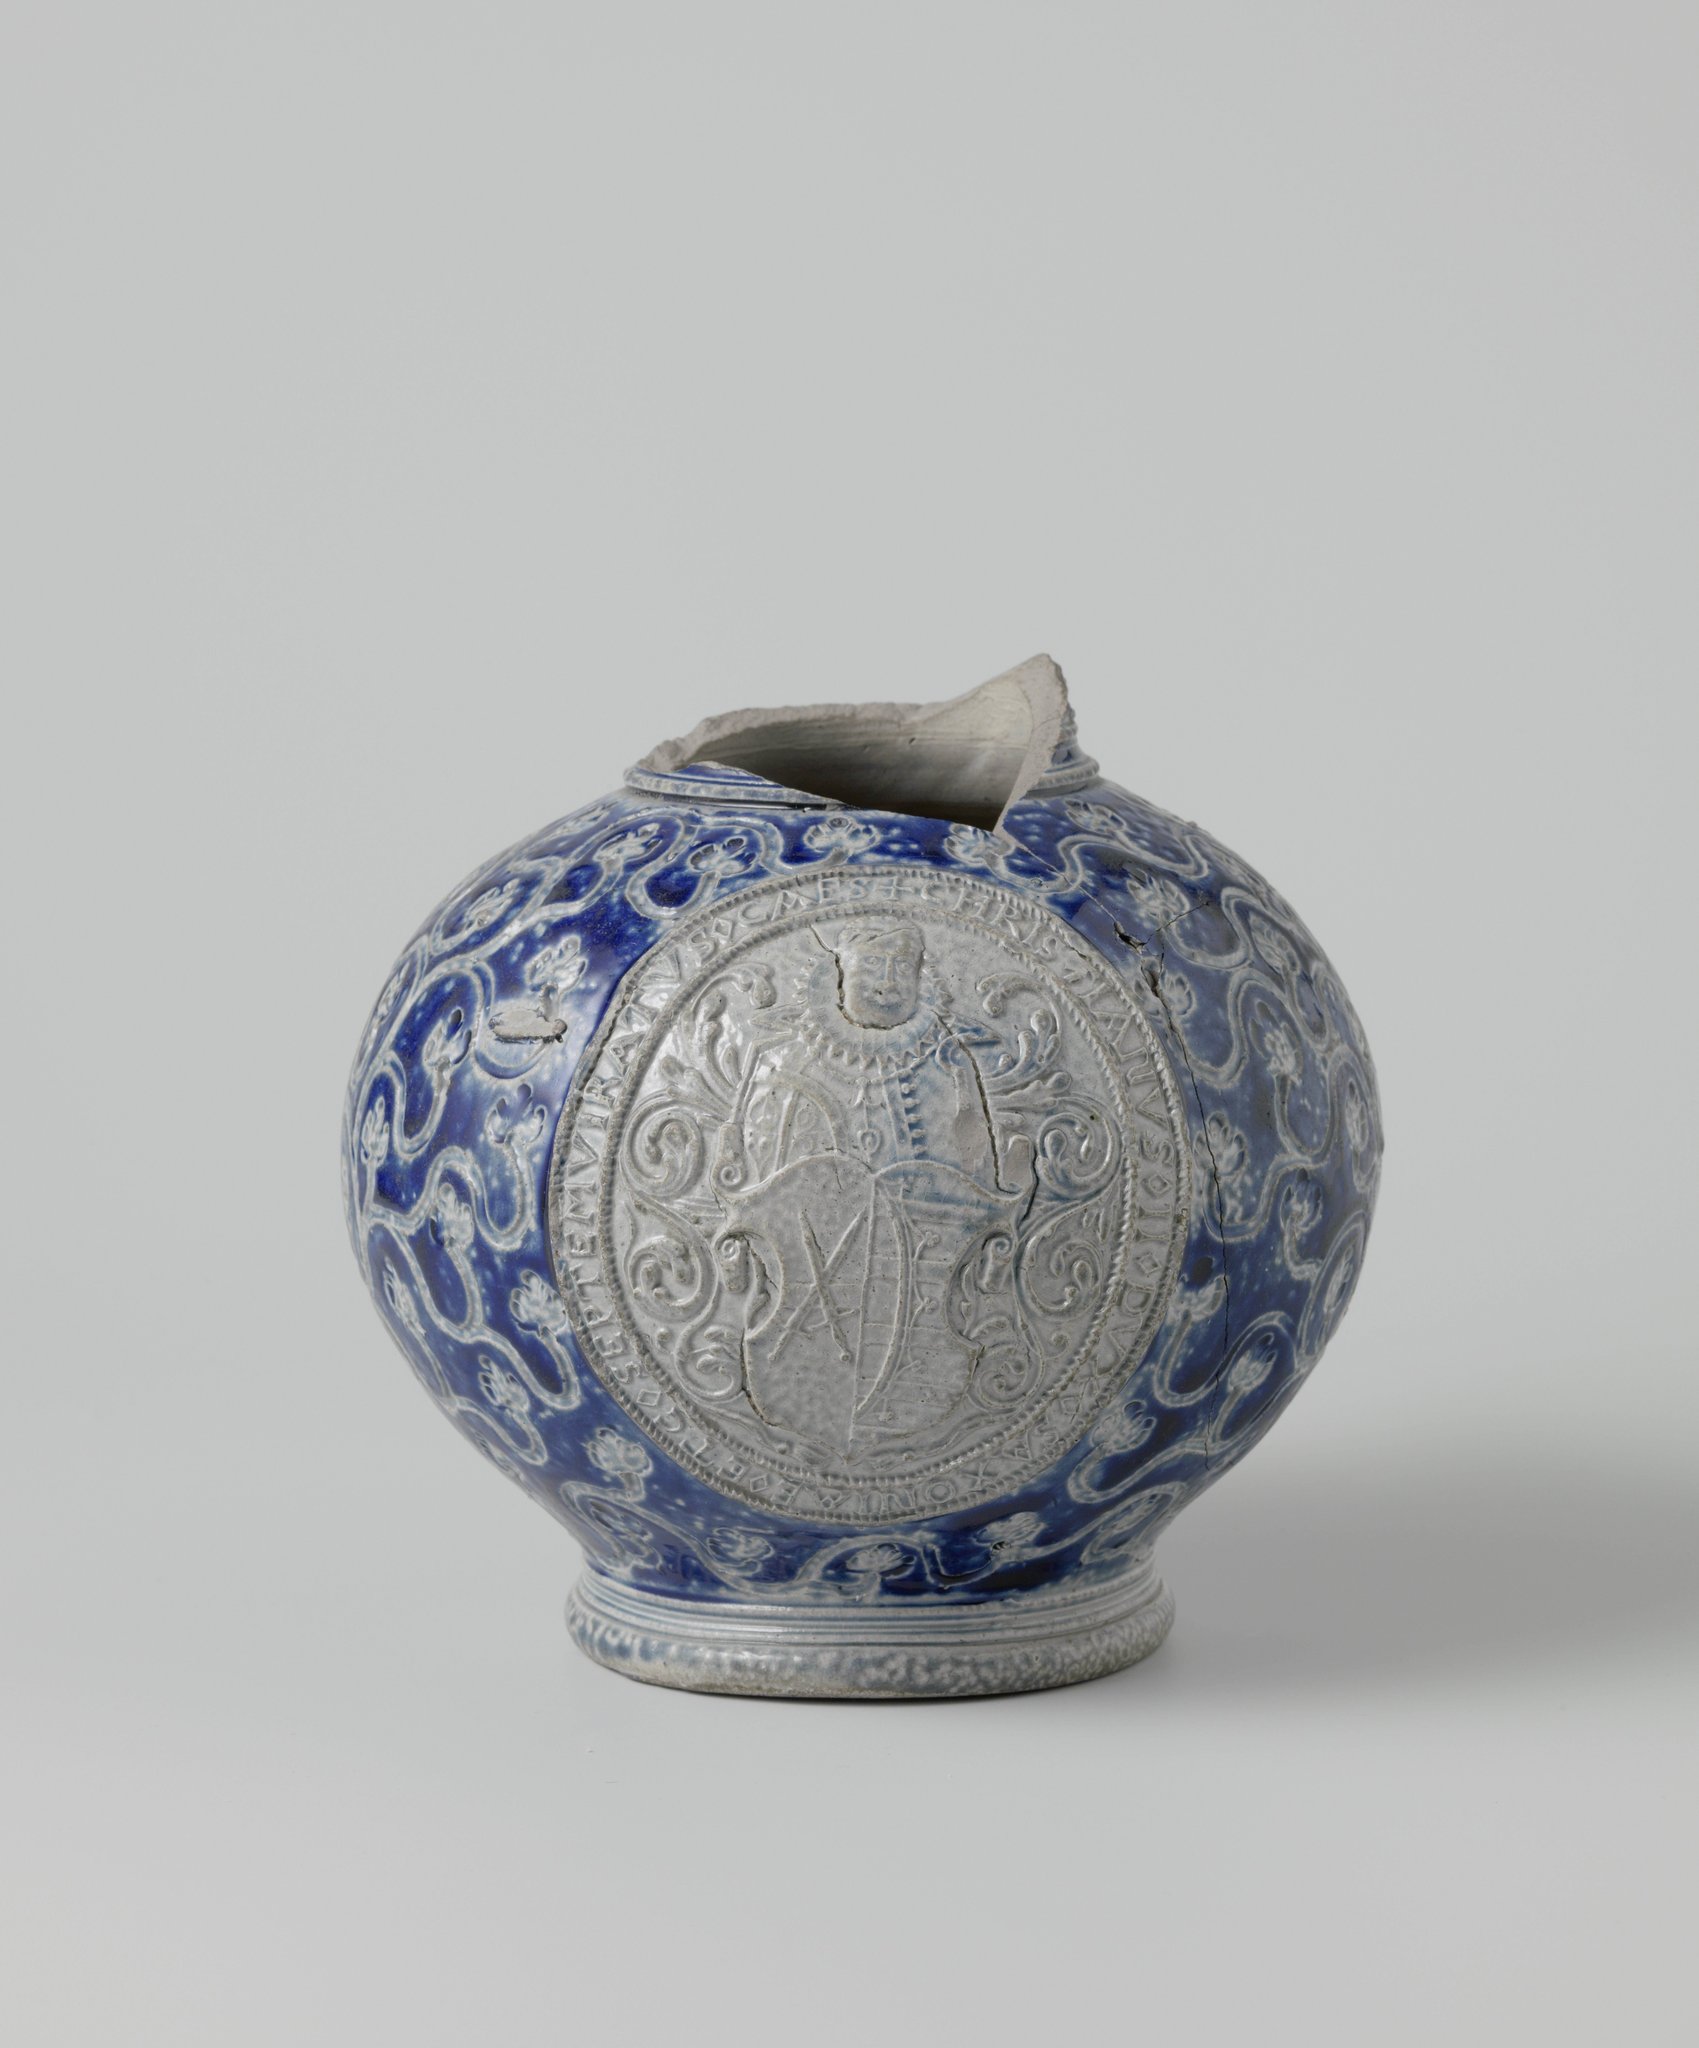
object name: fragment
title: Fragment of a jug with a portrait of Christan II, Elector of Saxony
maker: Anonymous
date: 1590-1620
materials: cobalt, glaze, stoneware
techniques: printing, firing, forming, relief, turning, vitrification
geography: raeren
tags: keurvorst, christiaan ii van saksen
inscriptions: inscription: ‘CHRISTIANVS II DVX SAXONIAE ETC SEPTEMVIRATVS CAES’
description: Fragment van een kruik van steengoed op standring met een bolvormig lichaam. Nek en oor ontbreken. Gedeeltelijk bedekt met kobaltblauw. Op de buik in reliëf een gedrukte en opgelegde medaillon met een portret van Christiaan II, keurvorst van Saxen, met als randschrift 'CHRISTIANVS II DVX SAXONIAE ETC SEPTEMVIRATVS CAES'. Het medaillon is omringd door ingegrifte ranken met gestempelde bloemen. Raeren.